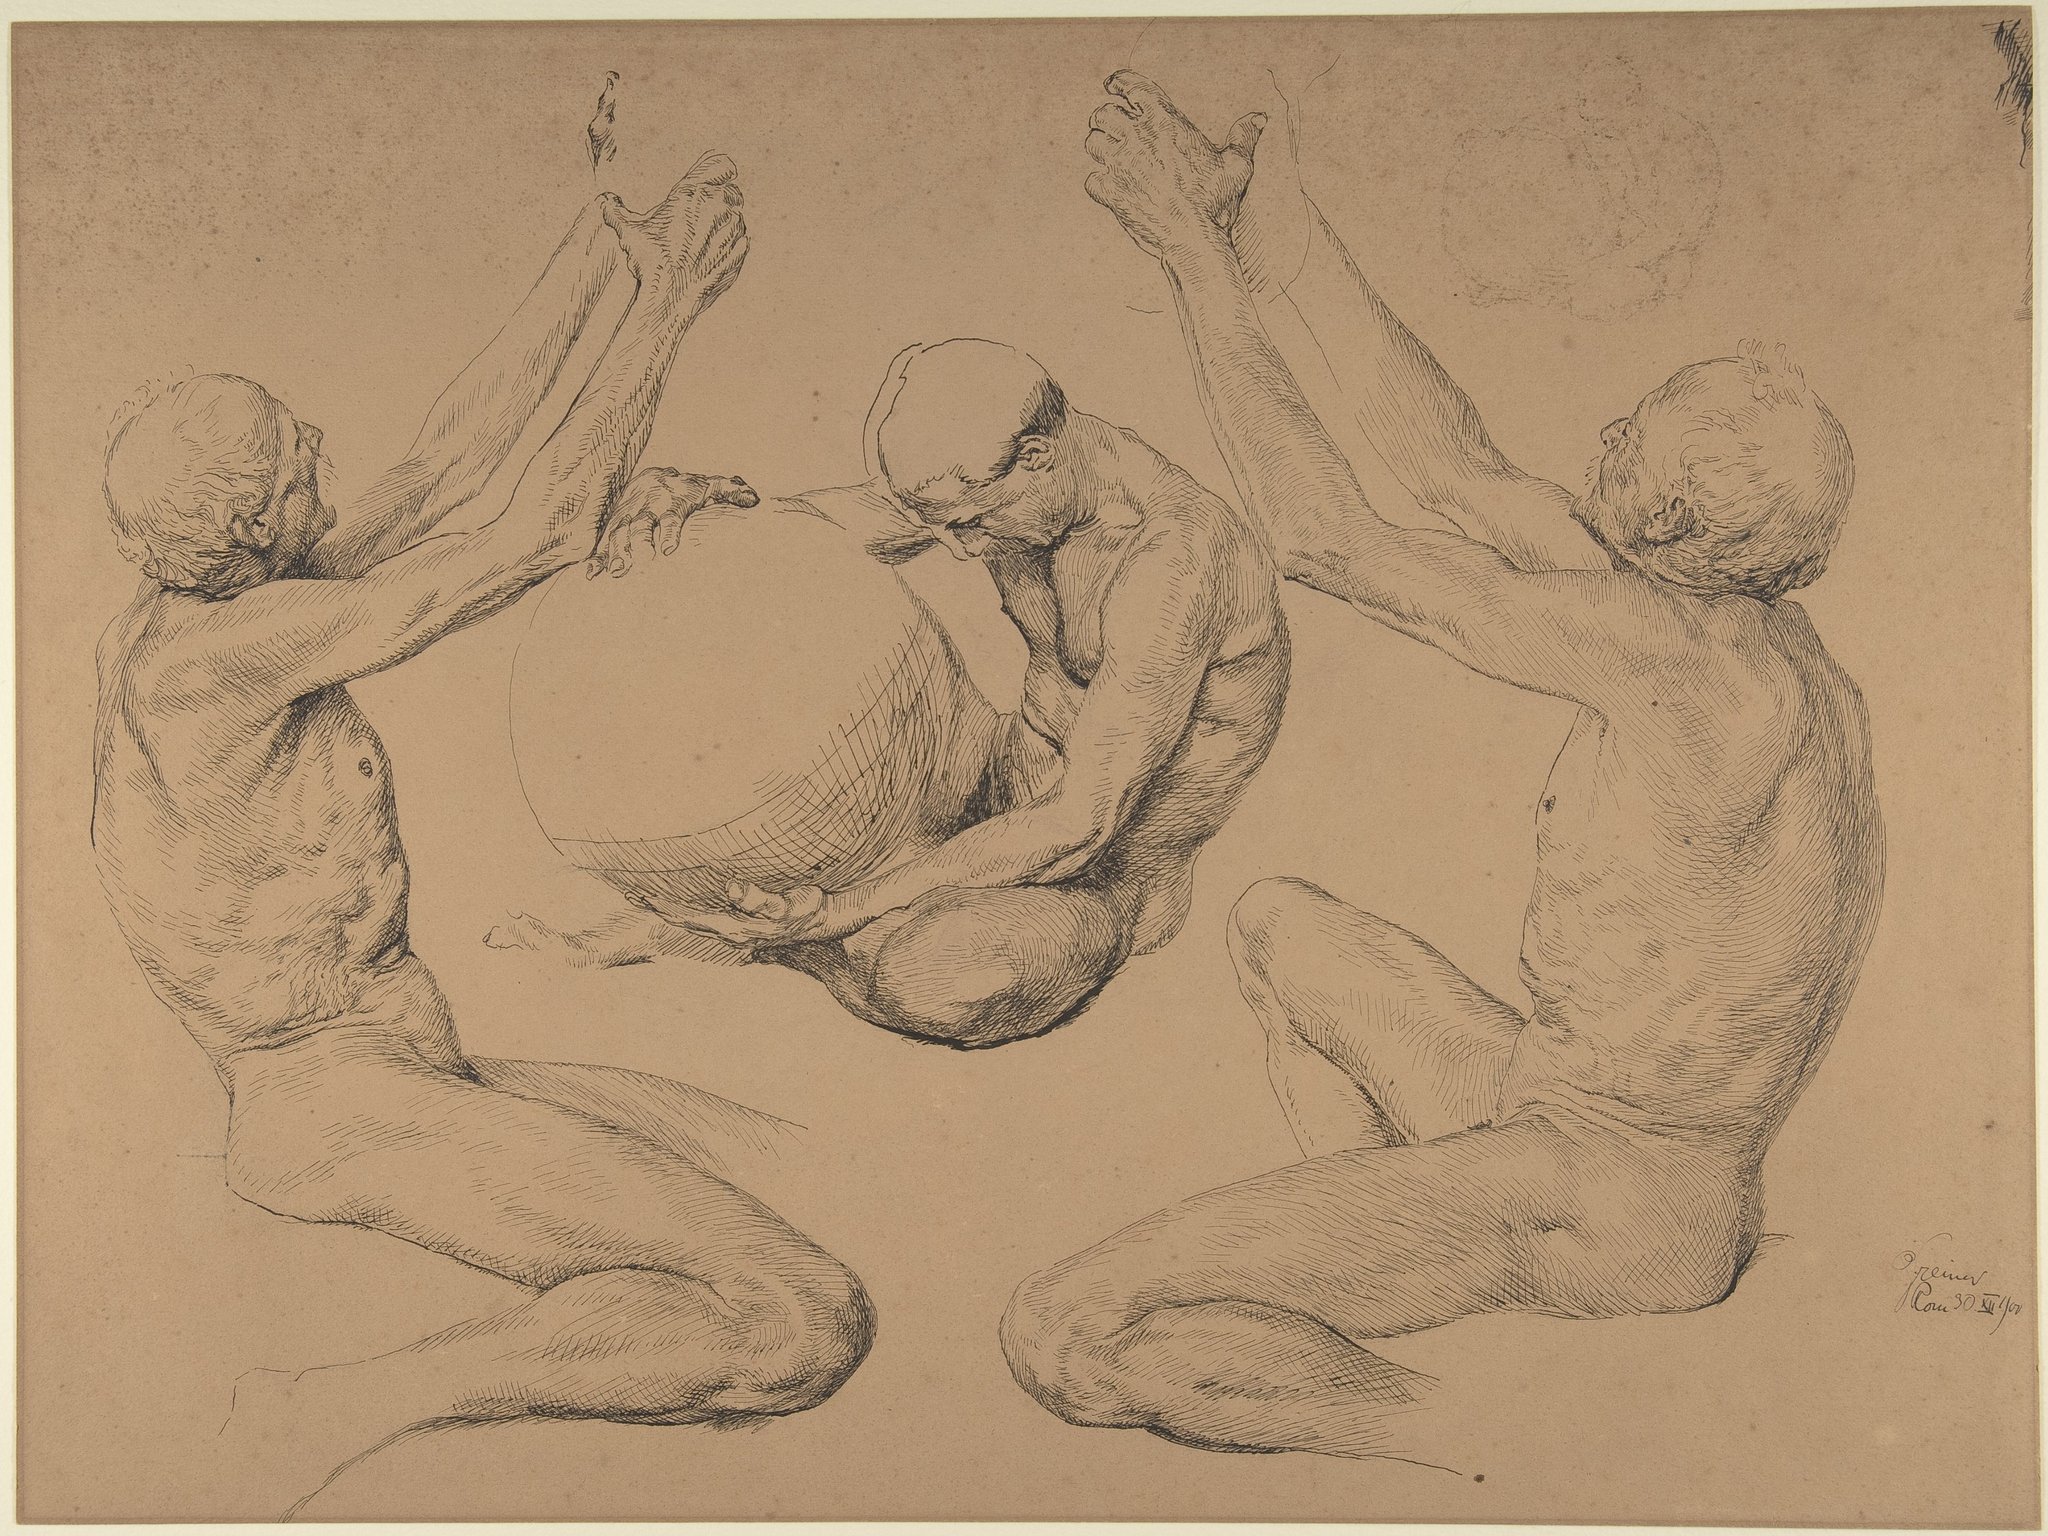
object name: drawing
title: Sheet of studies for "Ex Libris Victor Graf von Rex"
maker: otto greiner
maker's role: artist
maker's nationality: german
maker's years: 1869-1916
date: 1900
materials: ink, paper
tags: male nudes,globes